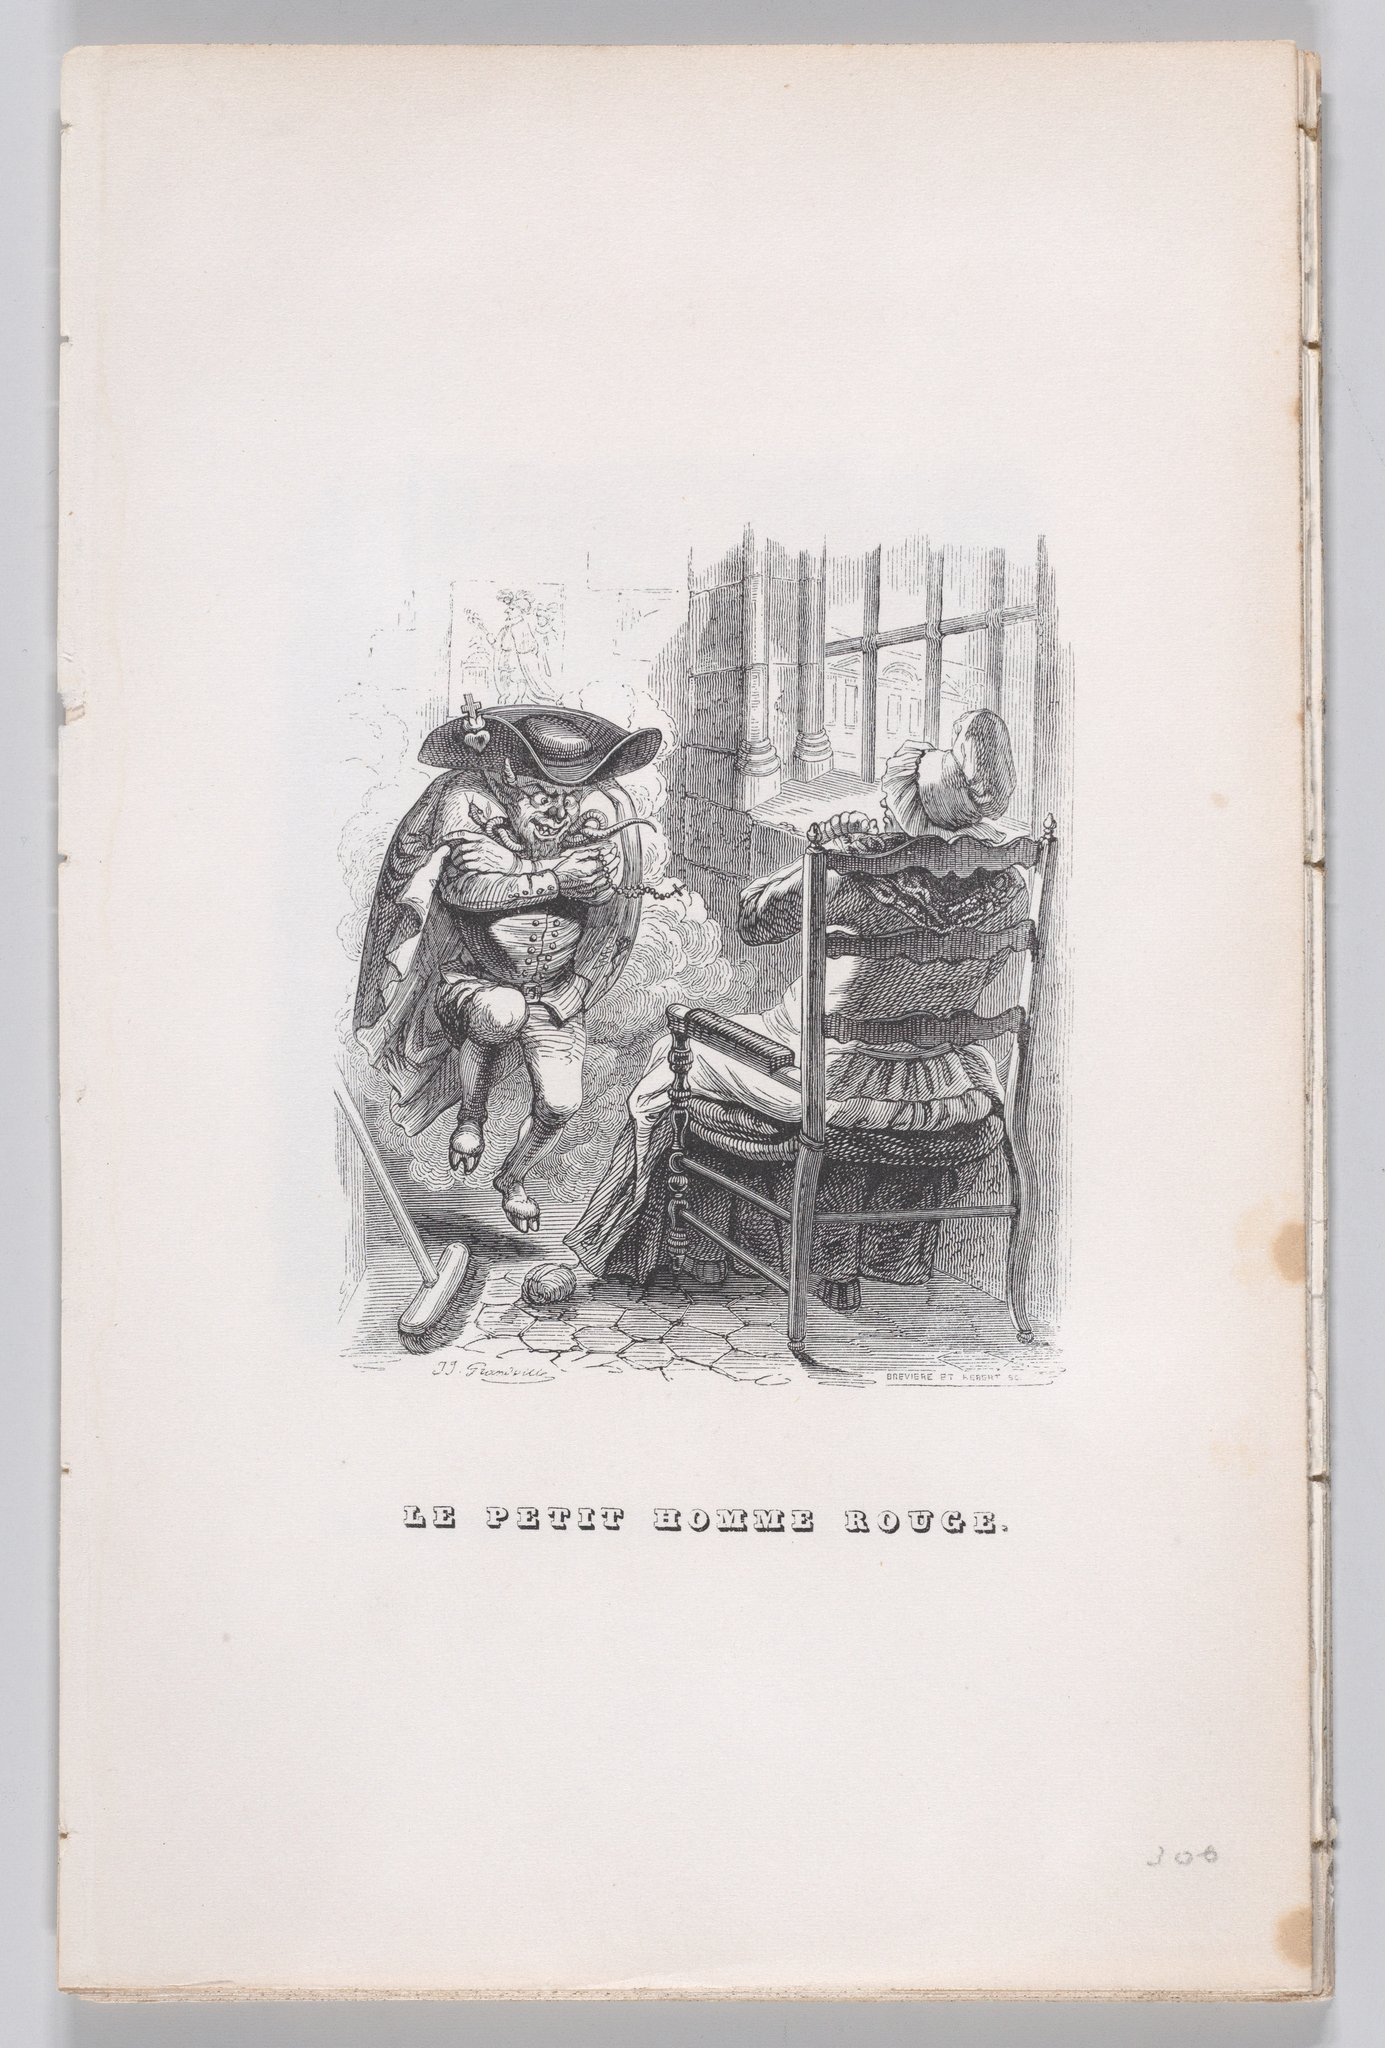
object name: print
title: The Little Red Man, from "The Complete Works of Béranger"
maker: j. j. grandville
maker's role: illustrator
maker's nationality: french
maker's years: 1803-1847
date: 1836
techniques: engraving